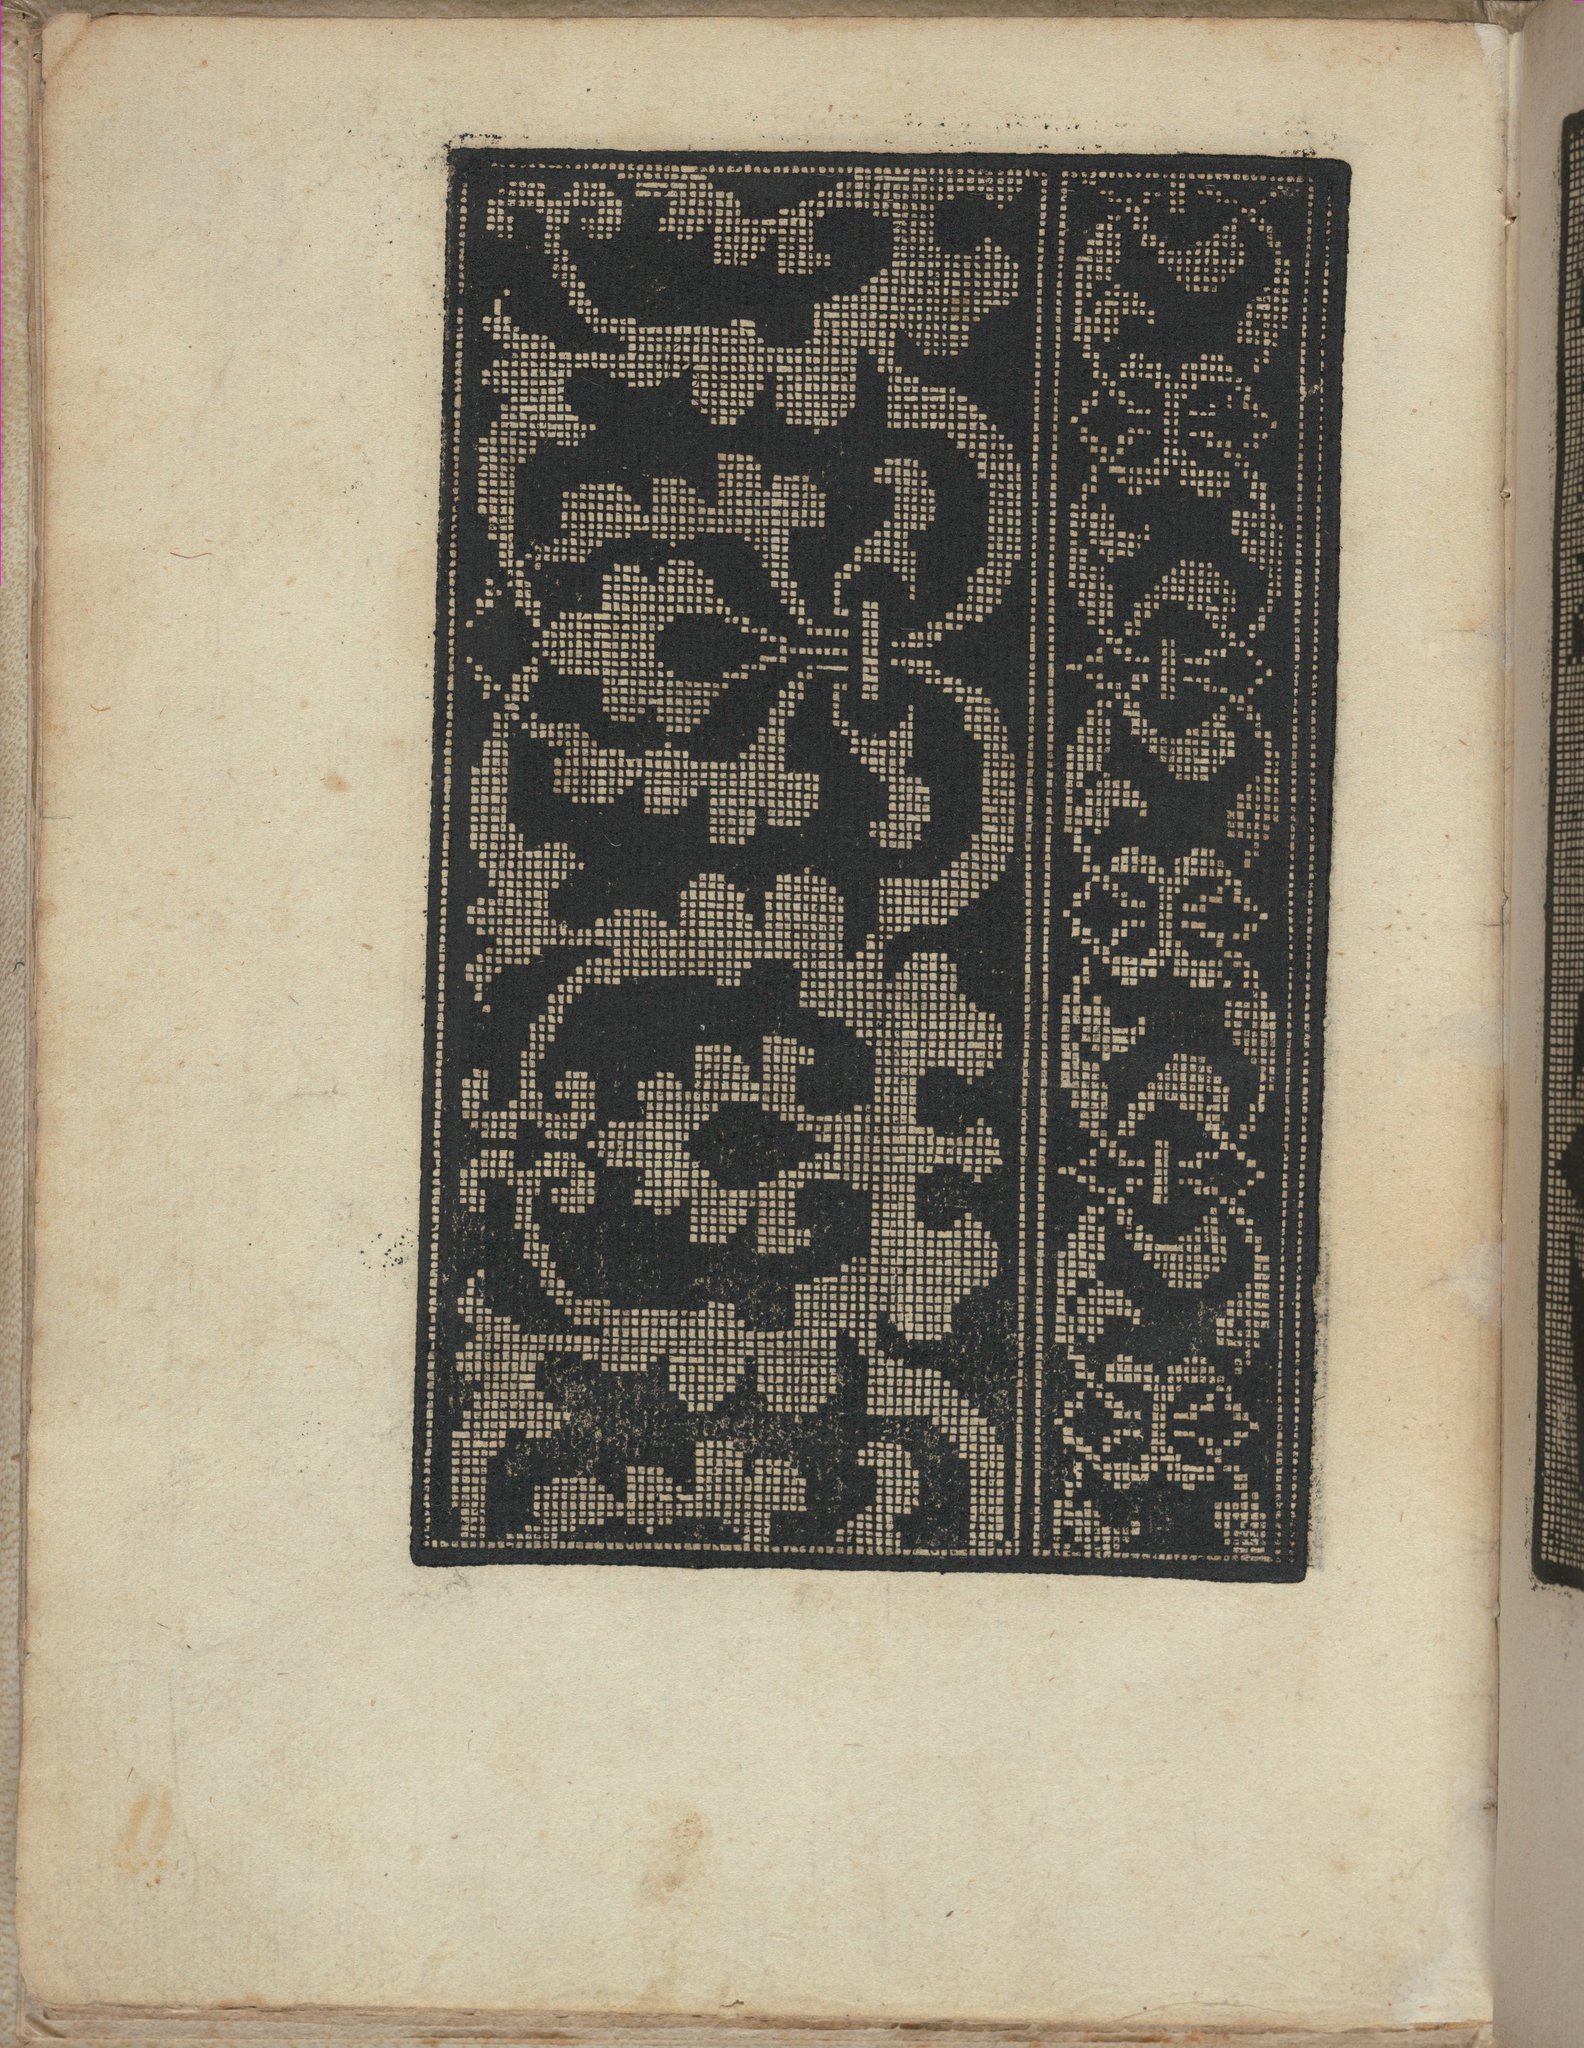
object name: book print ornament architecture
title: Esemplario di Lauori..., page 12 (verso)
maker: giovanni andrea vavassore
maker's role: publisher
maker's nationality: italian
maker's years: 1530-1573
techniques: woodcut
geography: venice